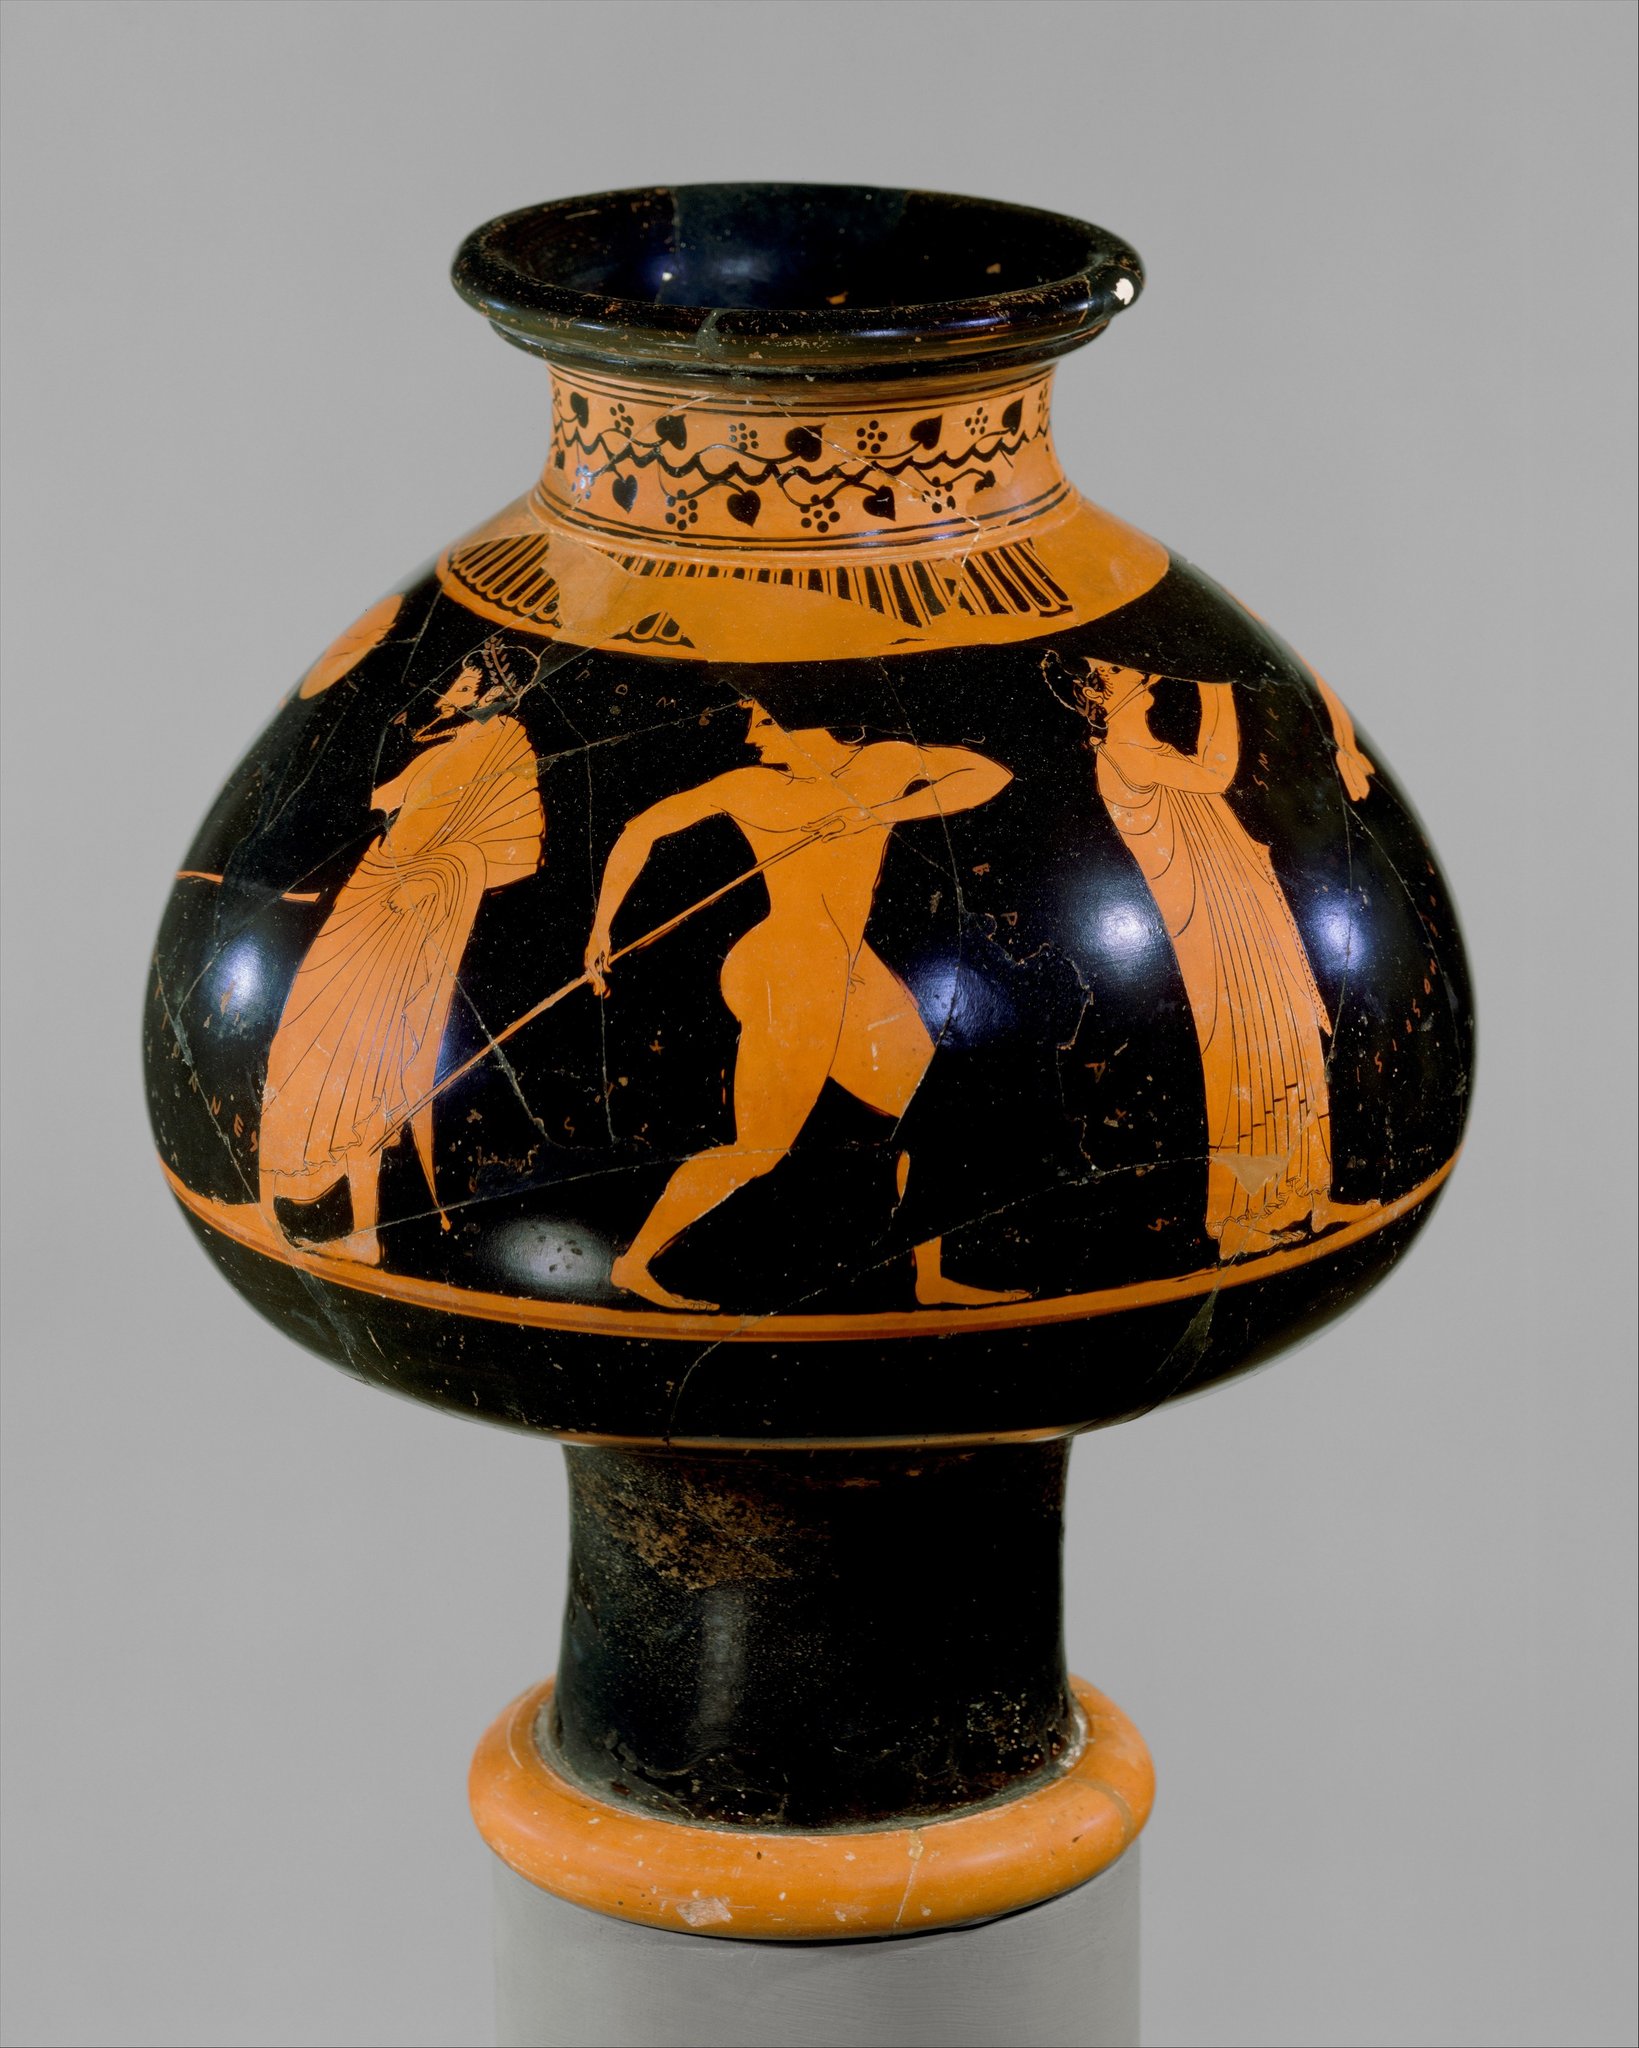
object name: psykter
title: Terracotta psykter (vase for cooling wine)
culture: greek, attic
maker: oltos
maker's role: artist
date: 520-510 BCE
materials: terracotta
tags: men,male nudes,athletes